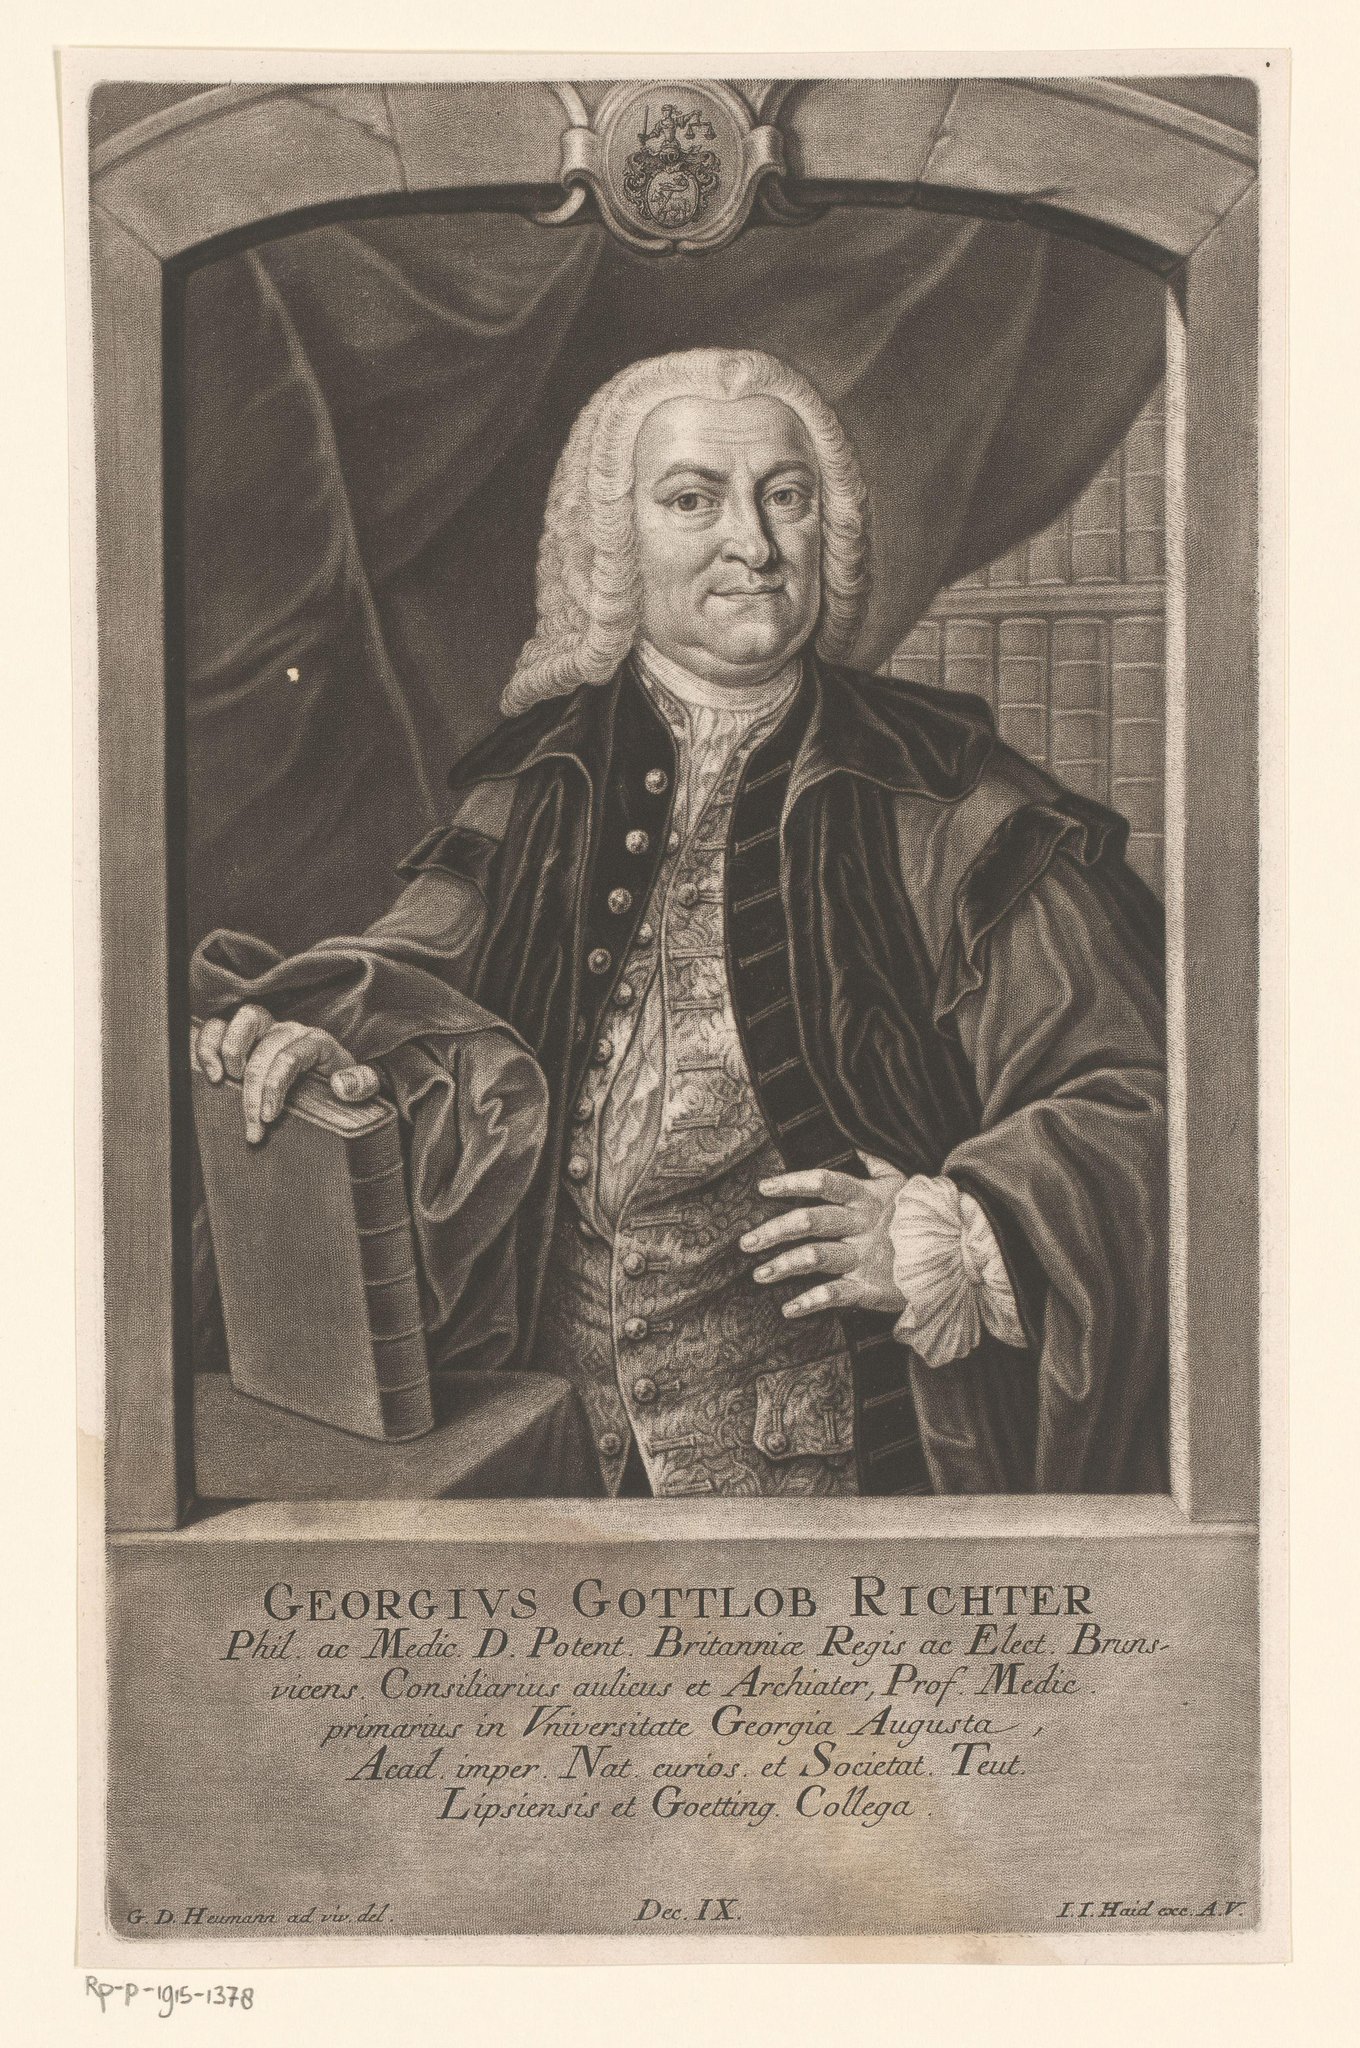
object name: print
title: Portret van Georg Gottlob Richter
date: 1752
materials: paper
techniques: etching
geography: augsburg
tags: bookshelves, historical persons, armorial bearing, heraldry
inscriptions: collector's mark: Lugt 2228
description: Prent gebruikt voor: Brucker, Jacob. Bildersal heutiges Tages lebender und durch Gelahrheit berühmter Schrifftsteller. Augsburg: Johann Jacob Haid, 1752.